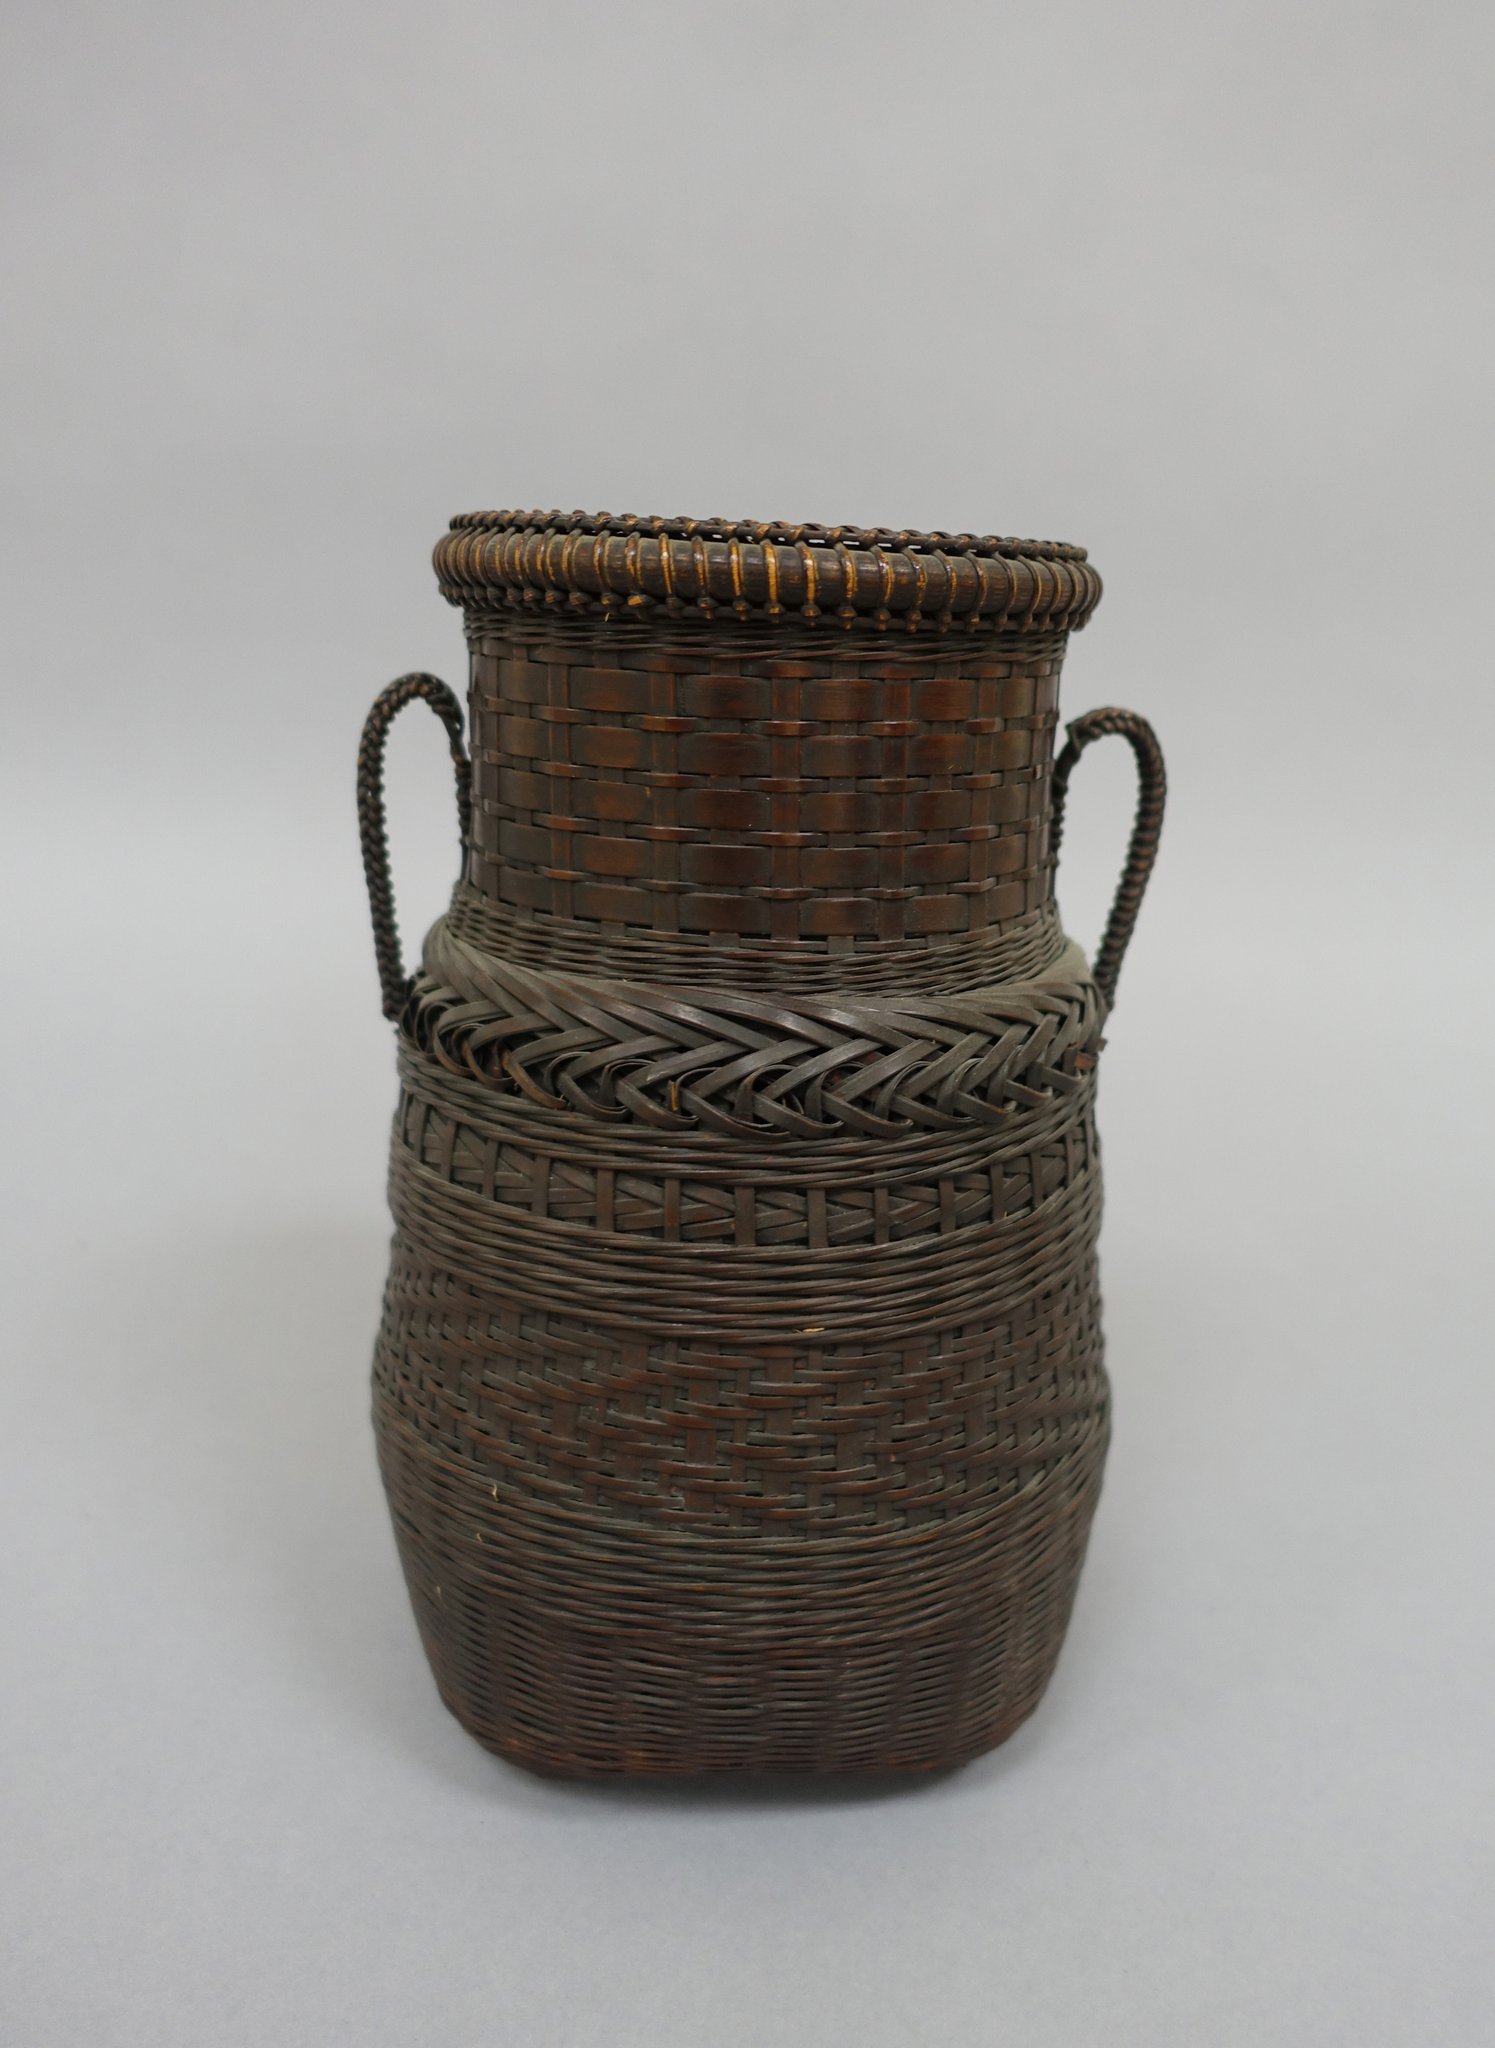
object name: basket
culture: japanese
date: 1801-1900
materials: bamboo